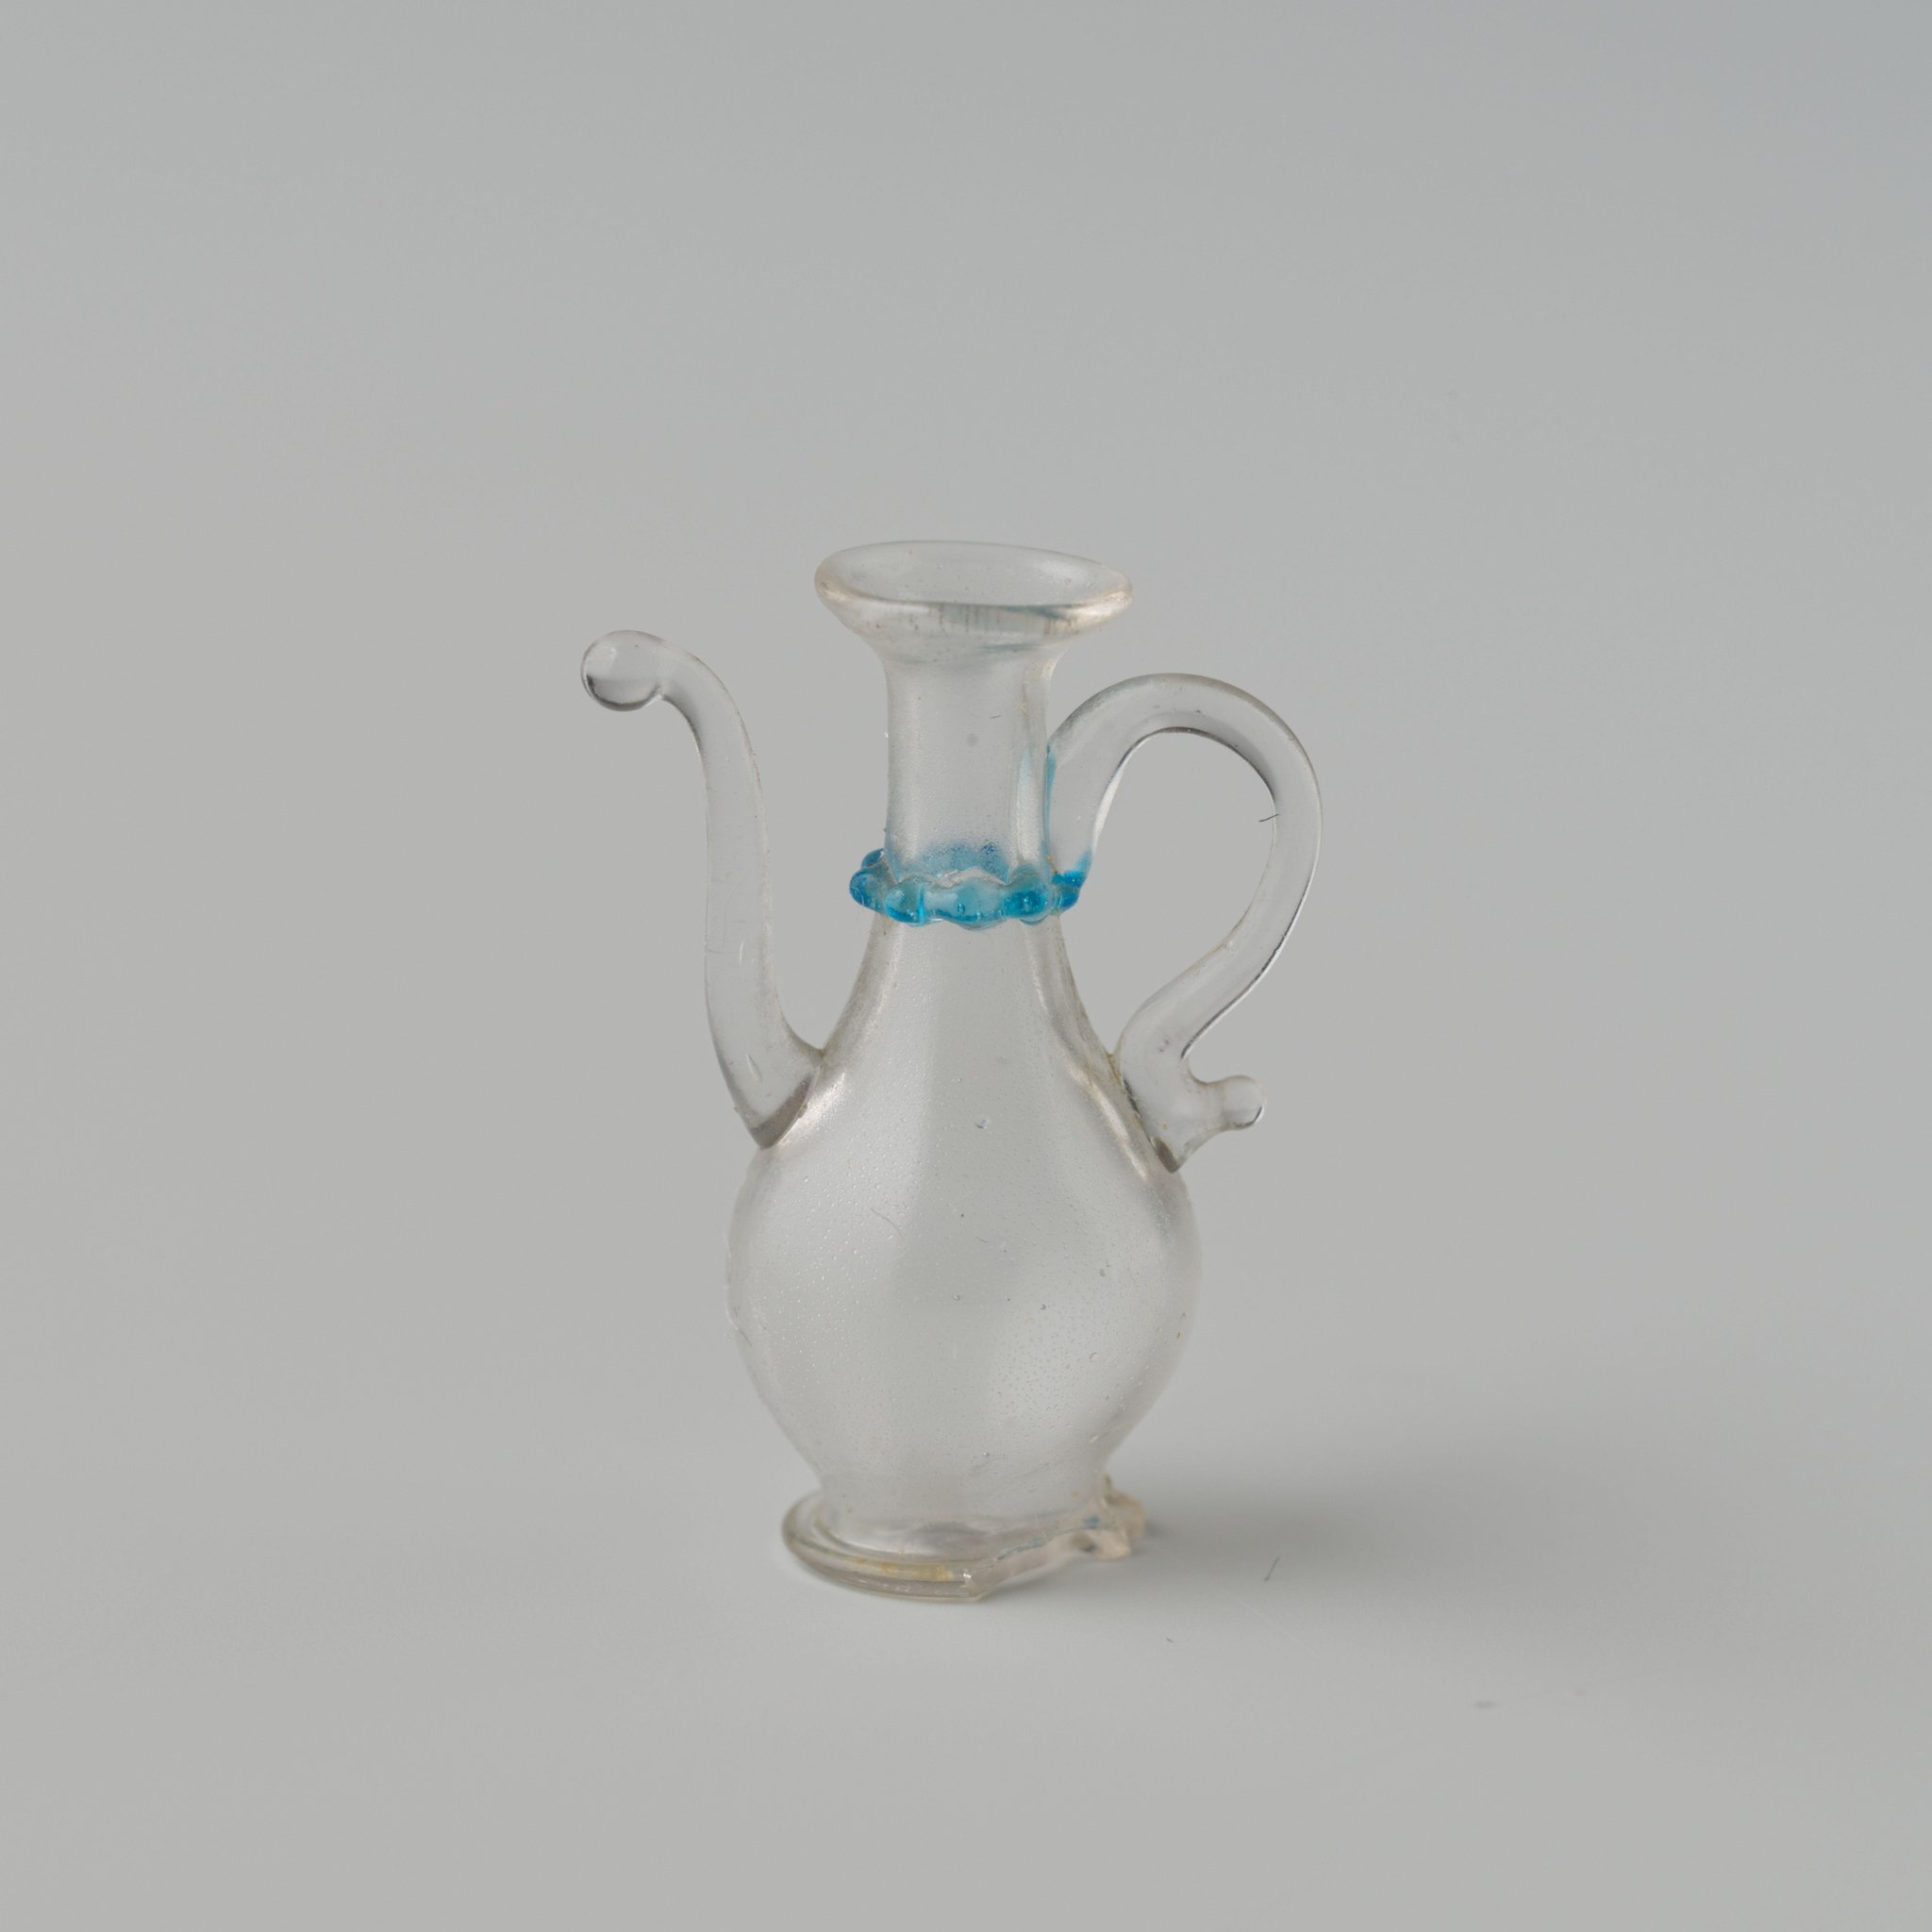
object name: ewer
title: Kan van helder kleurloos glas, glad slank model op vlakke iets naar buiten gebogen bodem; blauwe geknepen halsring, S-vormige massieve tuit en handvat.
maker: Anonymous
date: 1675-1710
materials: glass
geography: amsterdam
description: Eén van twee kannen van helder kleurloos glas. glad slank model op vlakke iets naar buiten gebogen bodem; blauwe geknepen halsring. S-vormige massieve tuit en handvat.